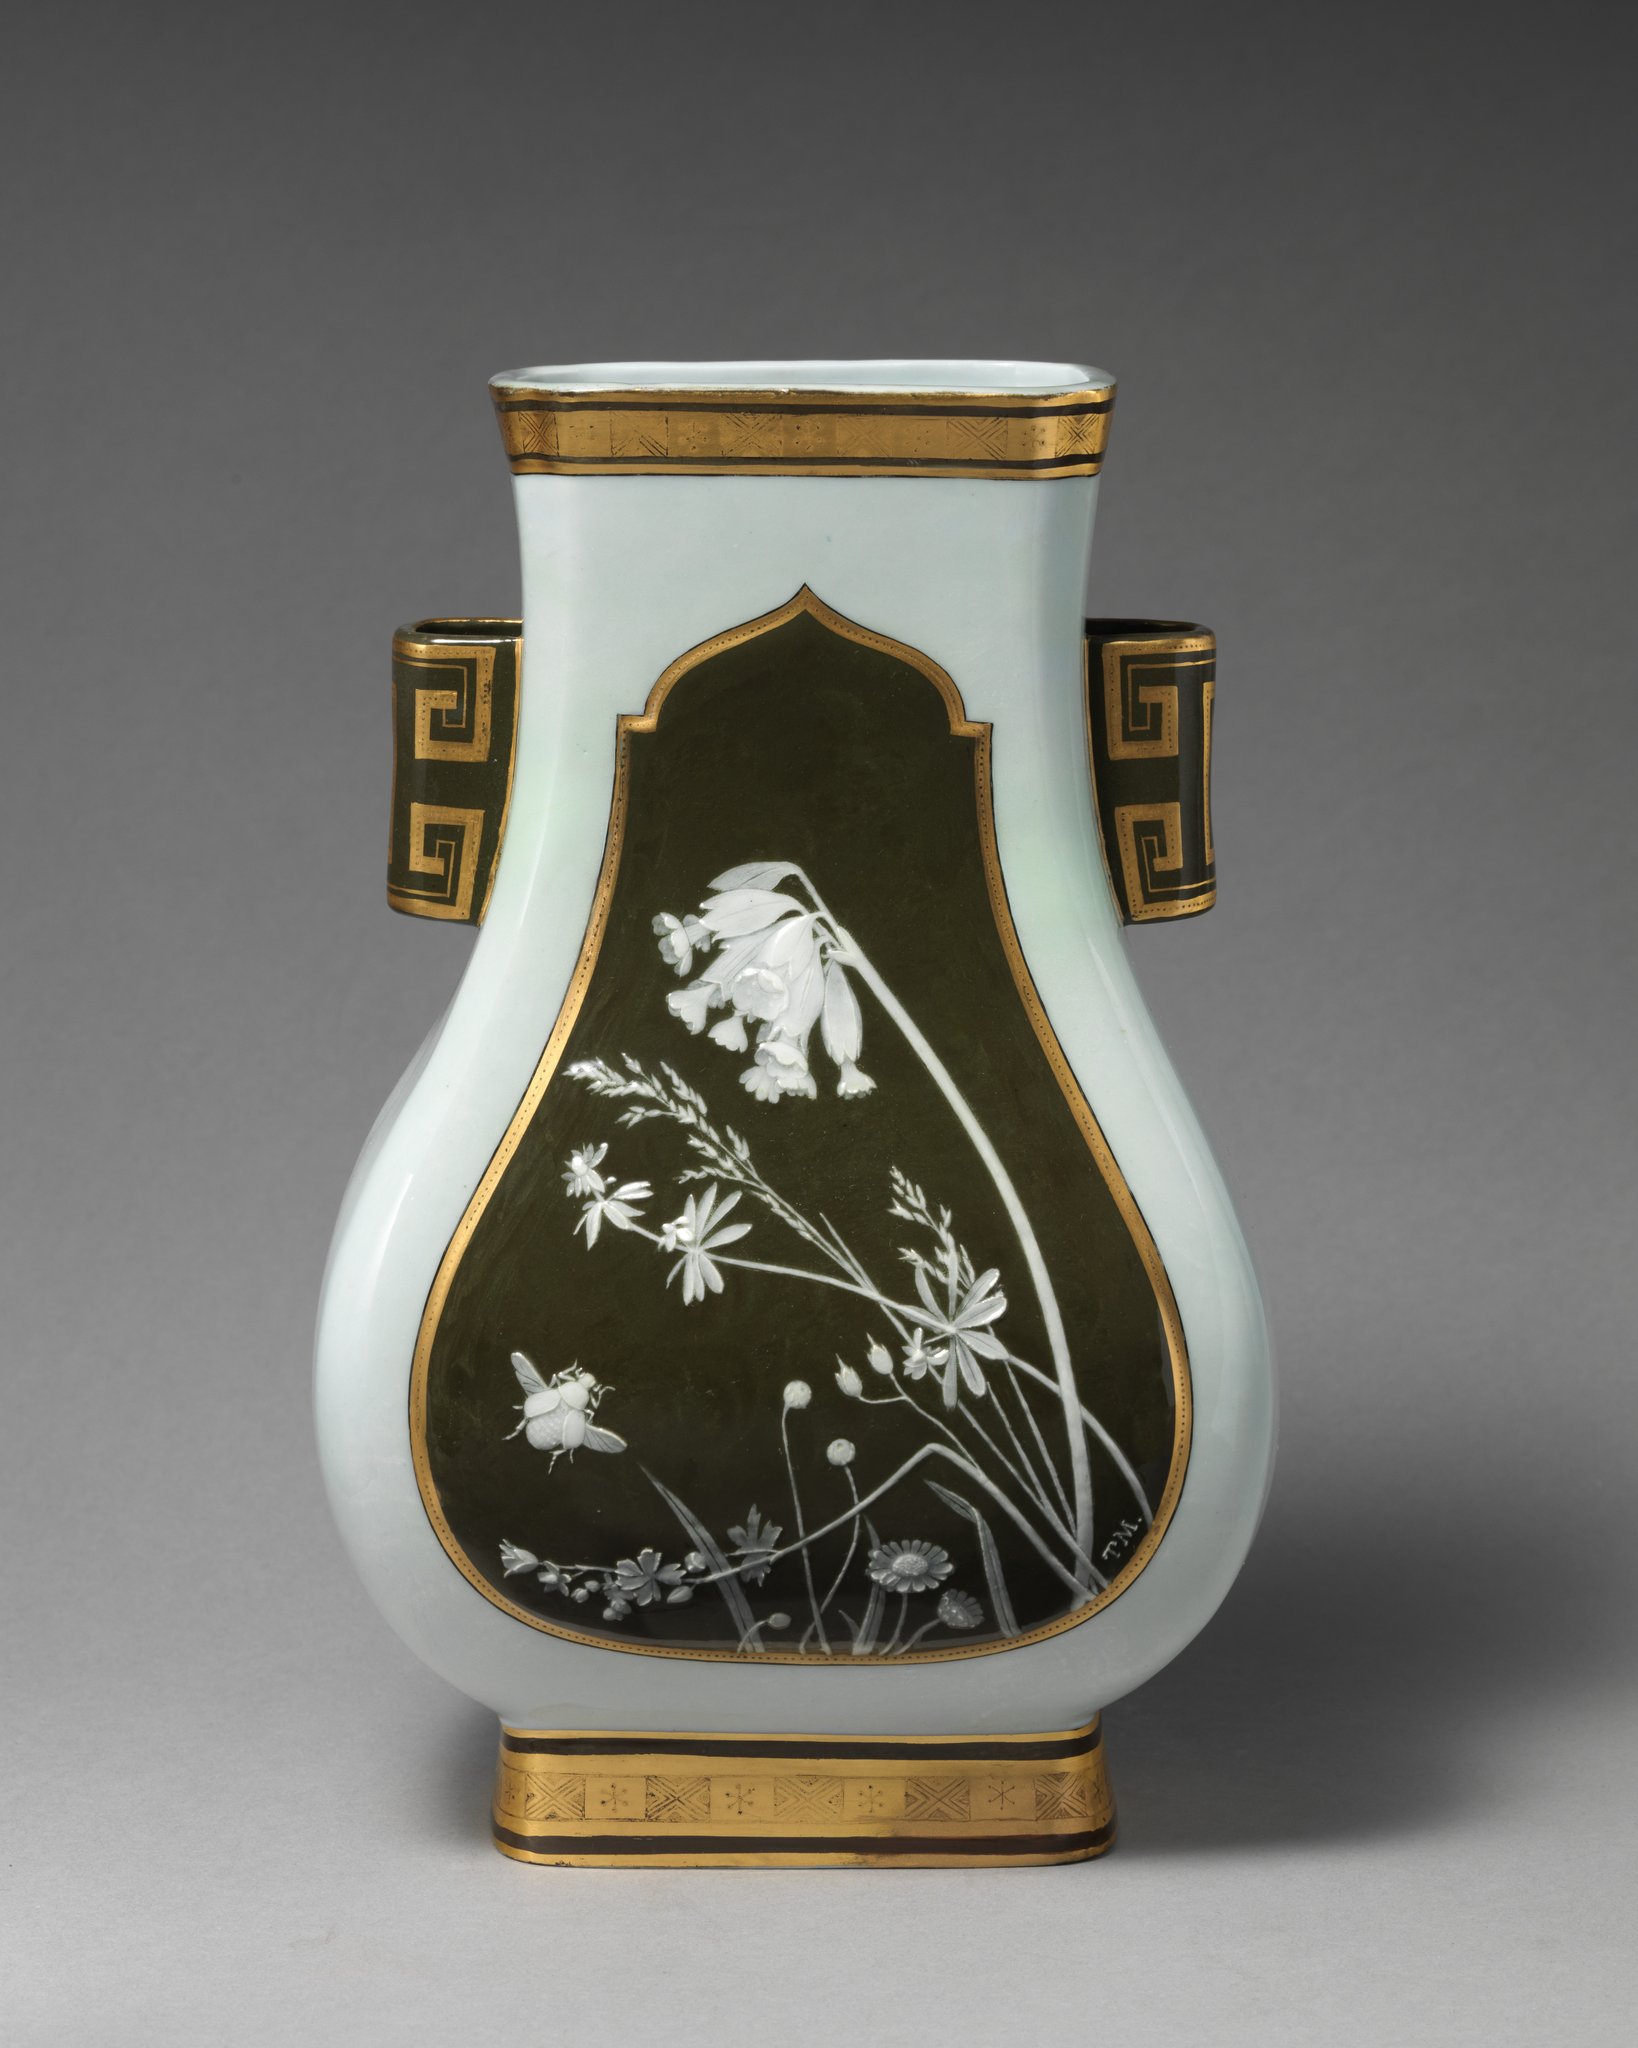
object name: vase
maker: minton(s)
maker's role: maker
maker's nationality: british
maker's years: 1793-2001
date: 1872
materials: porcelain